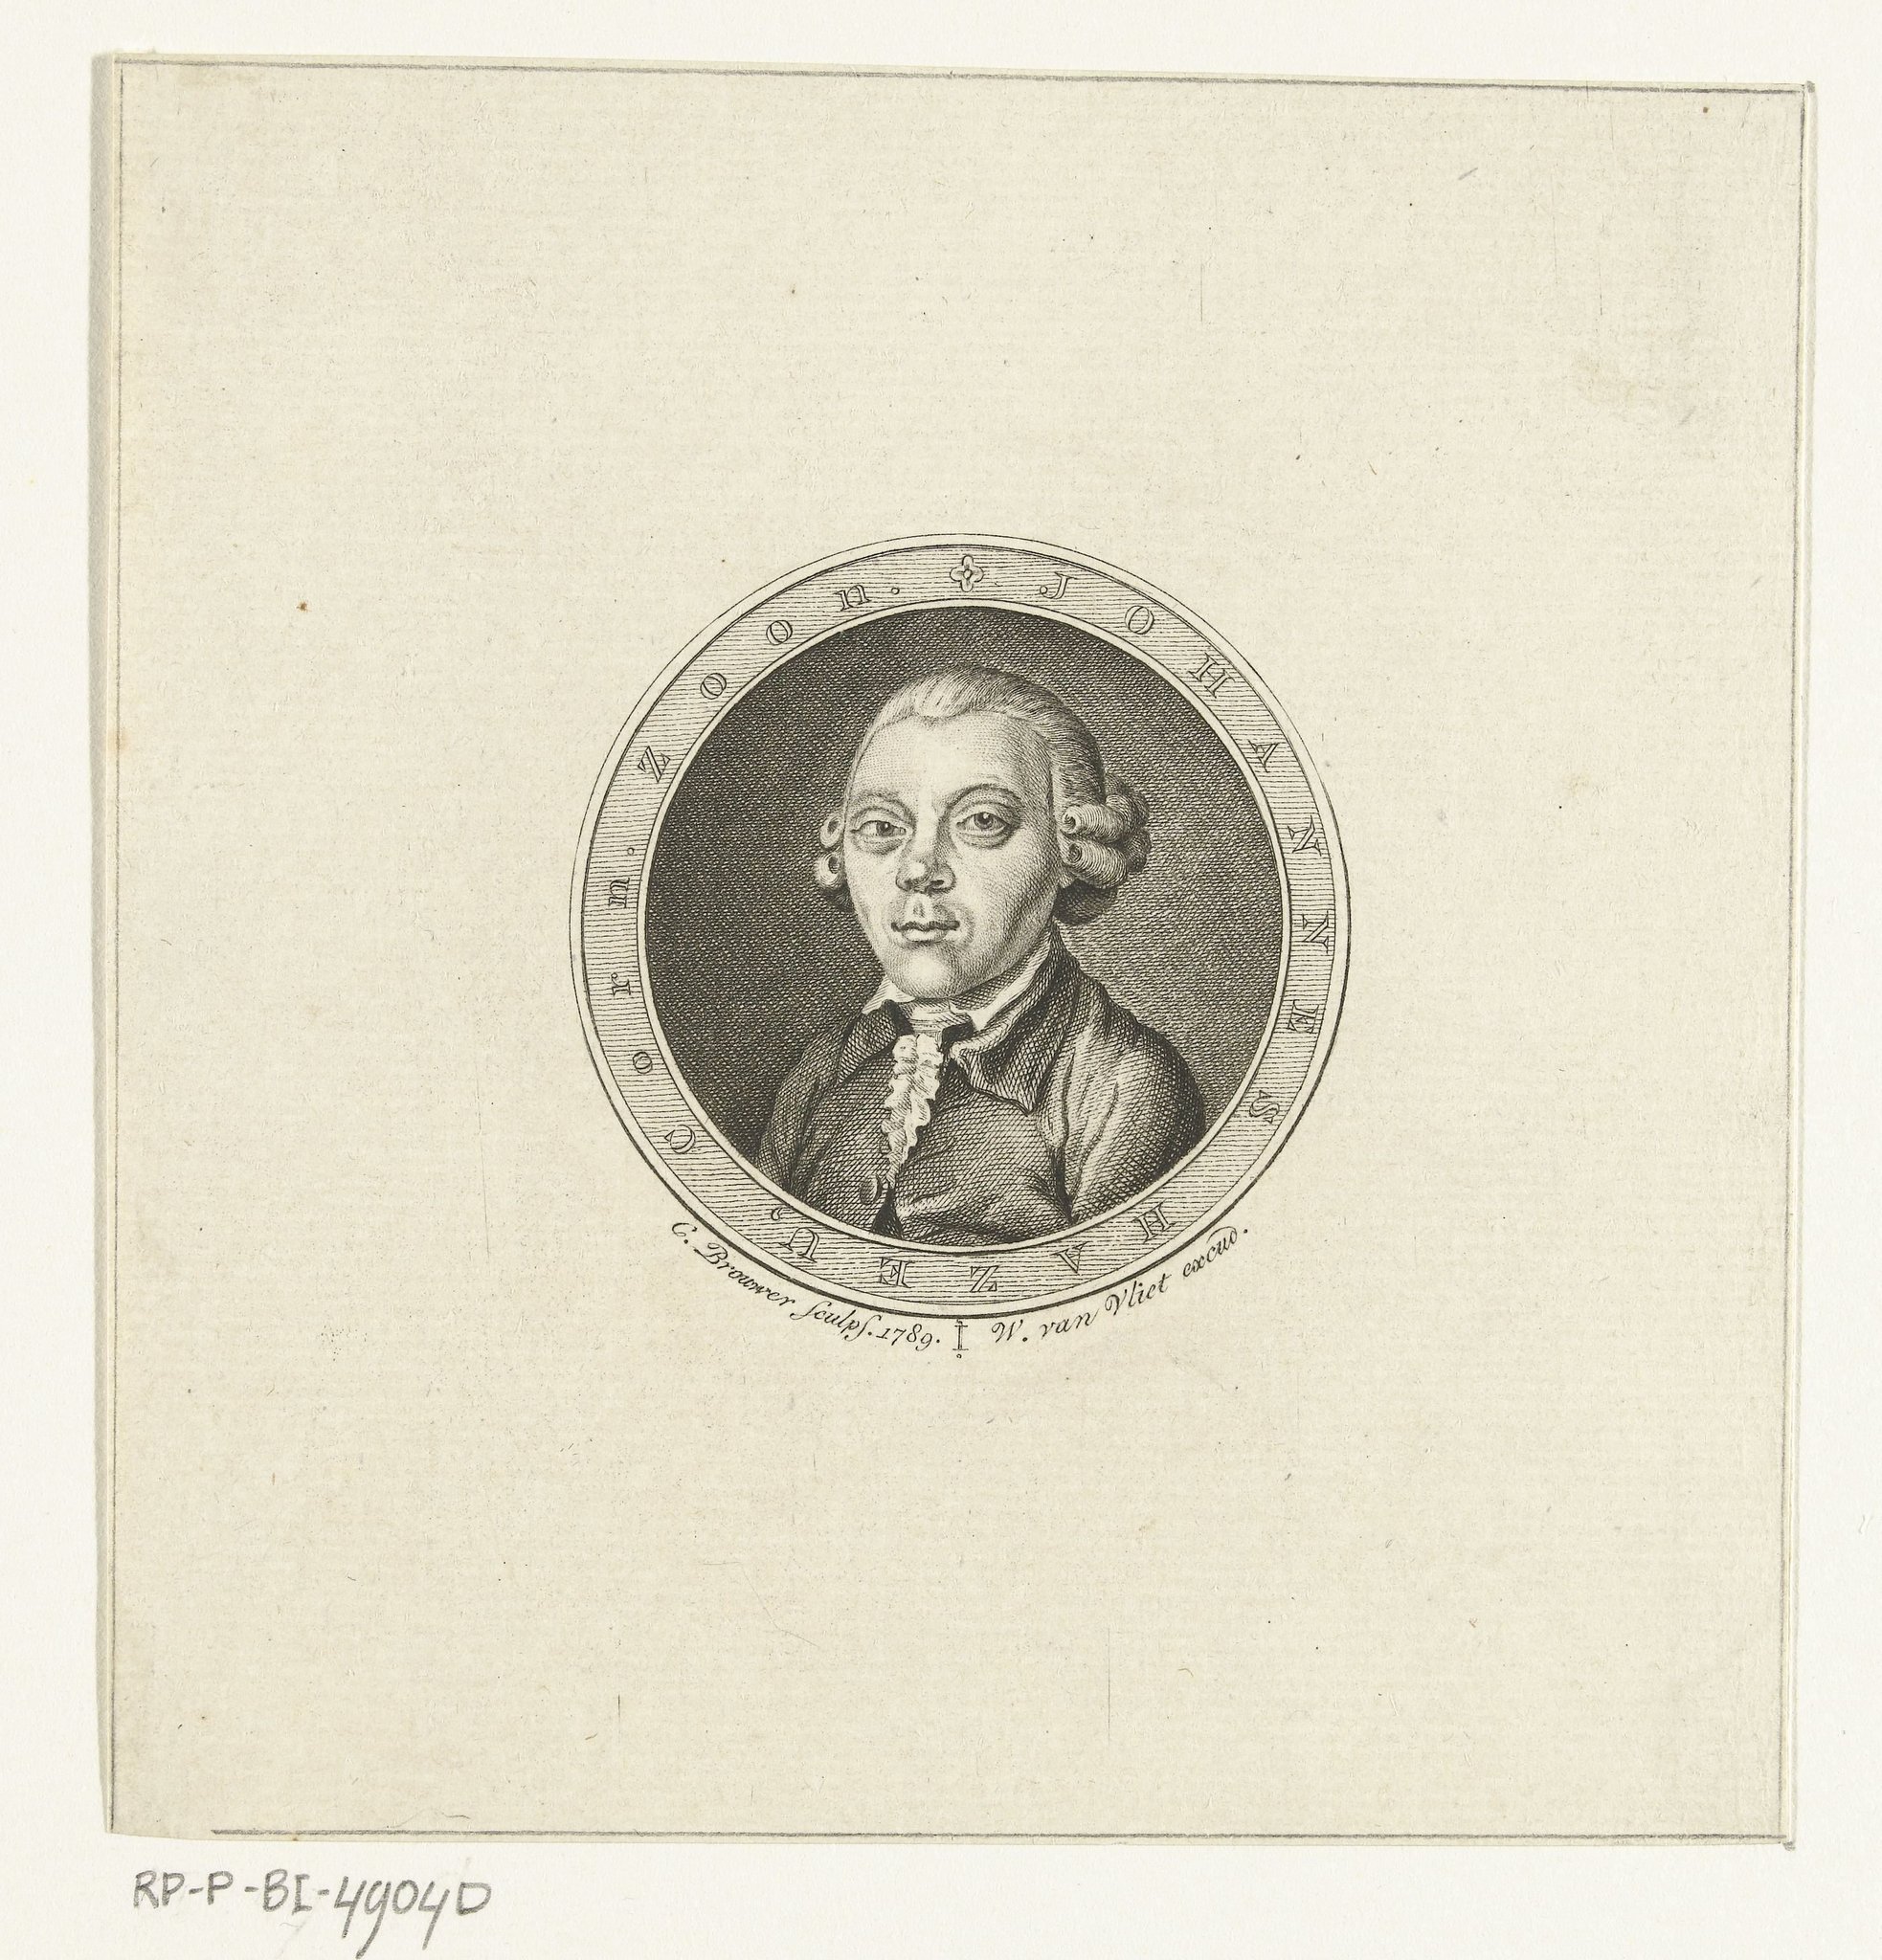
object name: print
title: Johannes Hazeu Corn. zoon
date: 1789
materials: paper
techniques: etching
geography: netherlands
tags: haarlem, johannes hazeu cornelisz., portrait of a writer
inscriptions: collector's mark: Lugt 2228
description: Portret van auteur Johannes Cornelisz. Hazeu, borststuk in ronde omlijsting met opschrift.